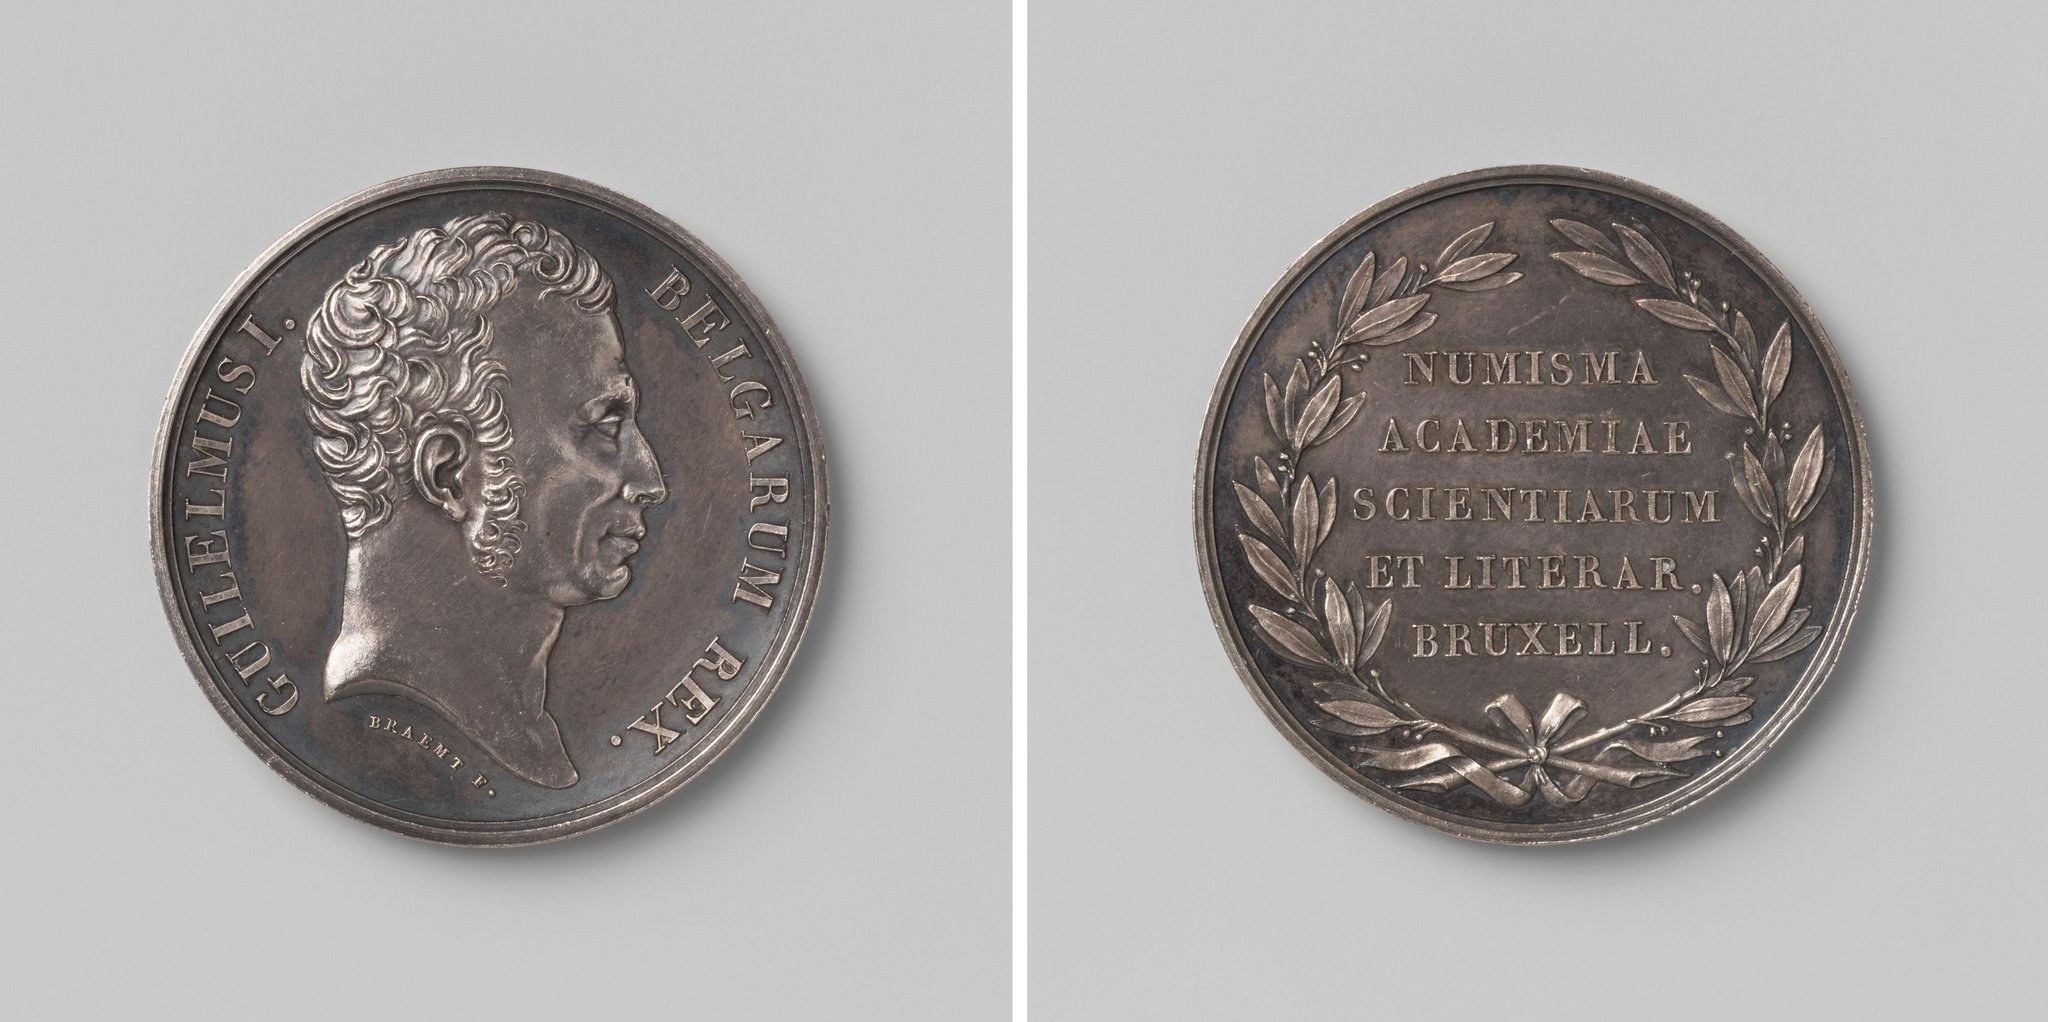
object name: medal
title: Koninklijke Academie van Wetenschappen en Letteren te Brussel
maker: joseph pierre braemt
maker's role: print maker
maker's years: 1796-1864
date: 1816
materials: silver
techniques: striking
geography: brussels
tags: the hague, berlin, william i of the netherlands, brussels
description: Zilveren penning. Voorzijde: borststuk man binnen omschrift. Keerzijde: opschrift binnen krans van olijftakken